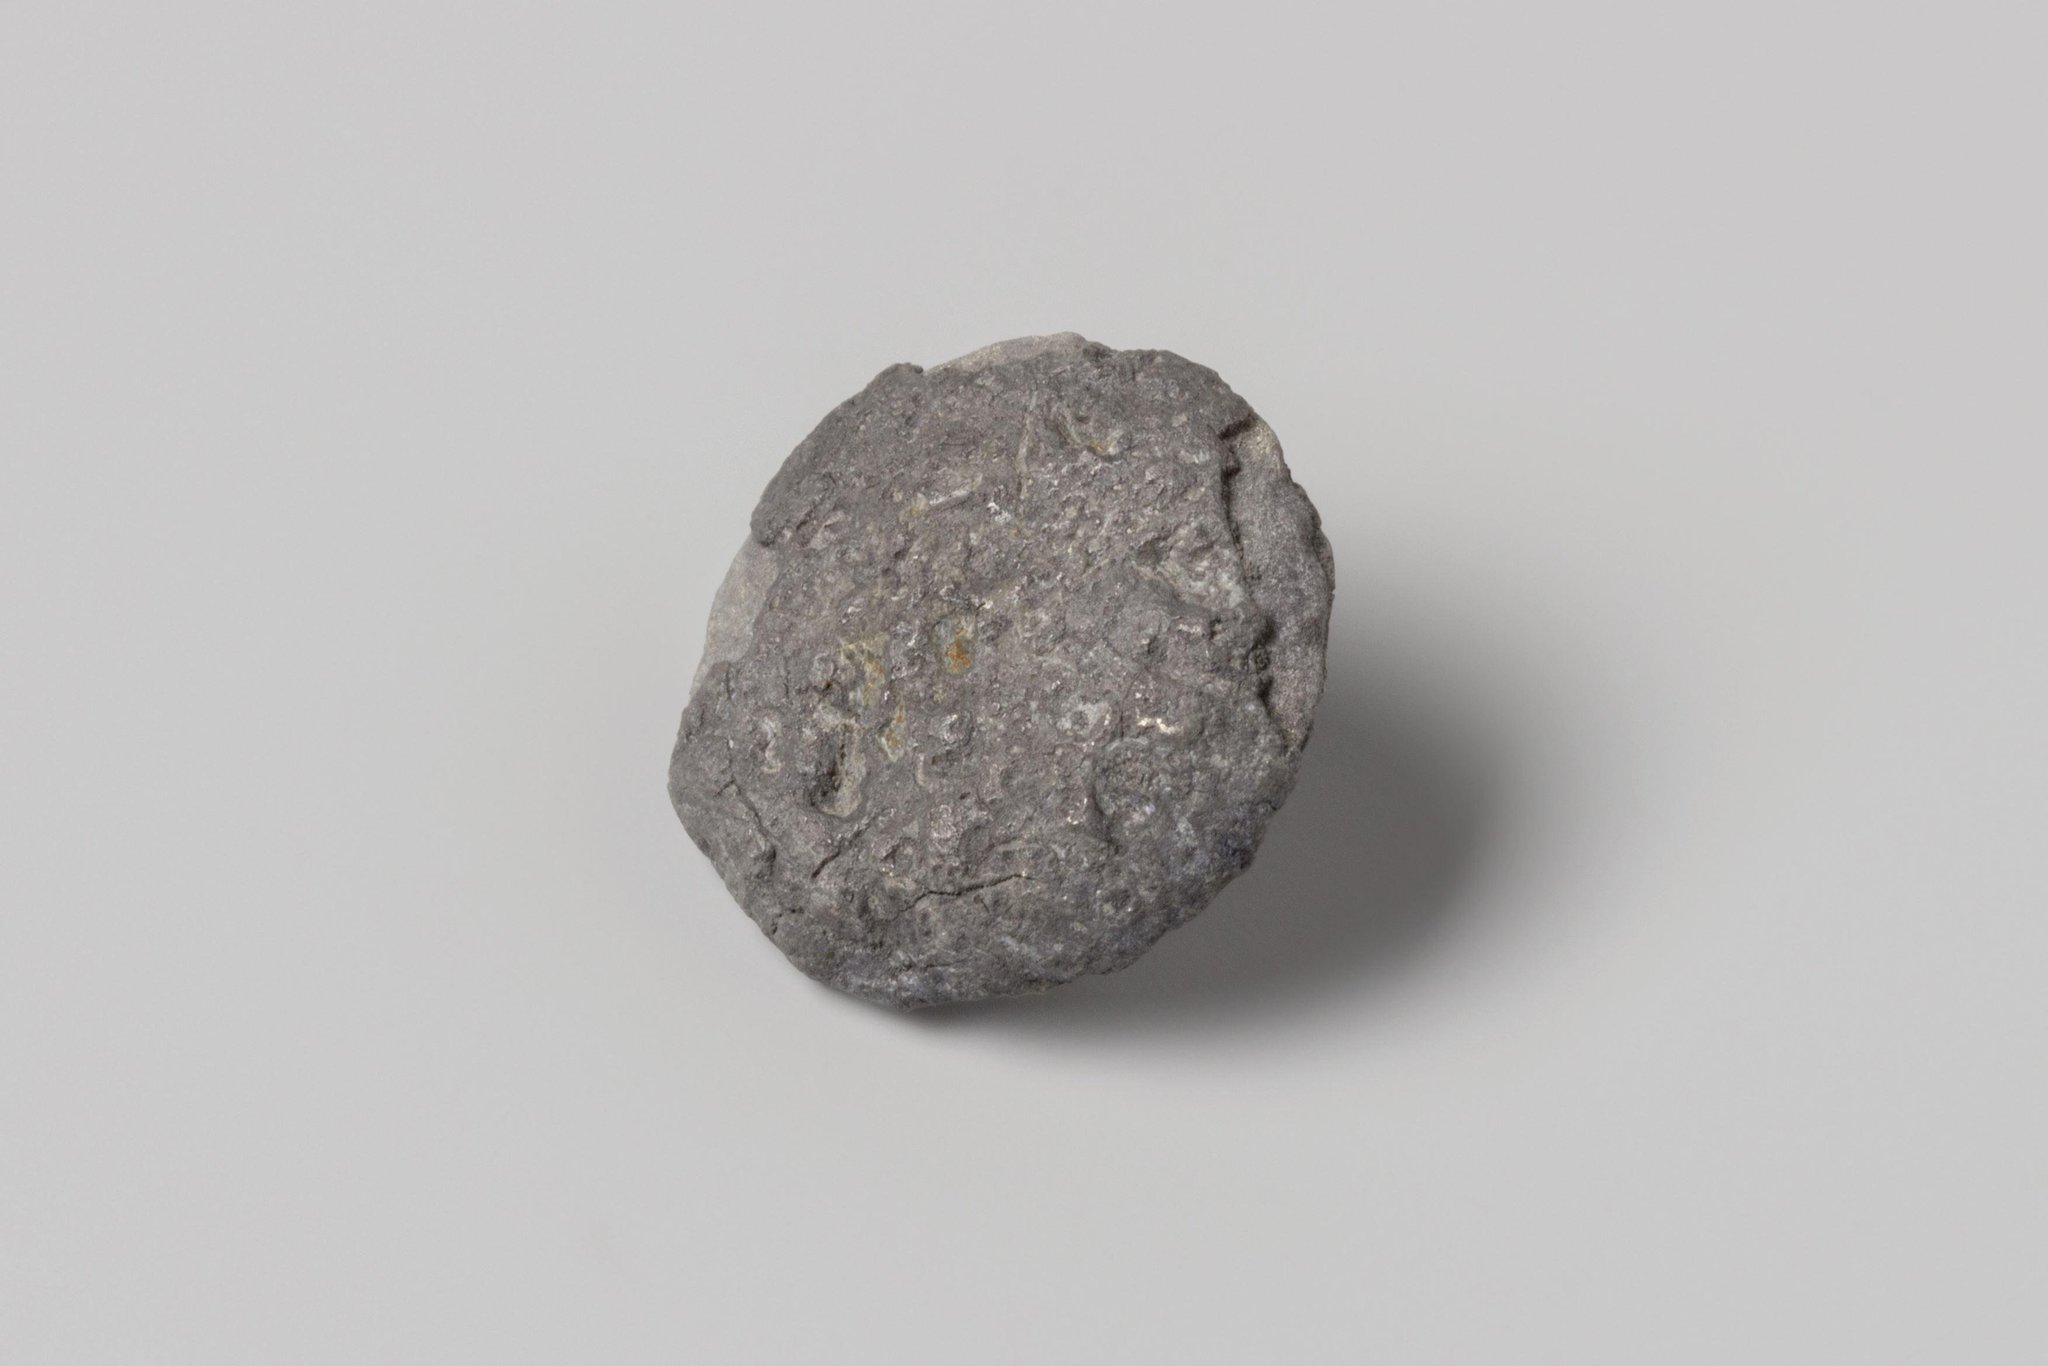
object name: button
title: Knoop uit het wrak van de Oost-Indiëvaarder Hollandia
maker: Anonymous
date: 1700-1743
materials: tin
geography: netherlands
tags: verenigde oostindische compagnie, hollandia (schip), annet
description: Knoop. (1) slightly domed, plain (1.9d, 0.4t), flat base, loop-shank